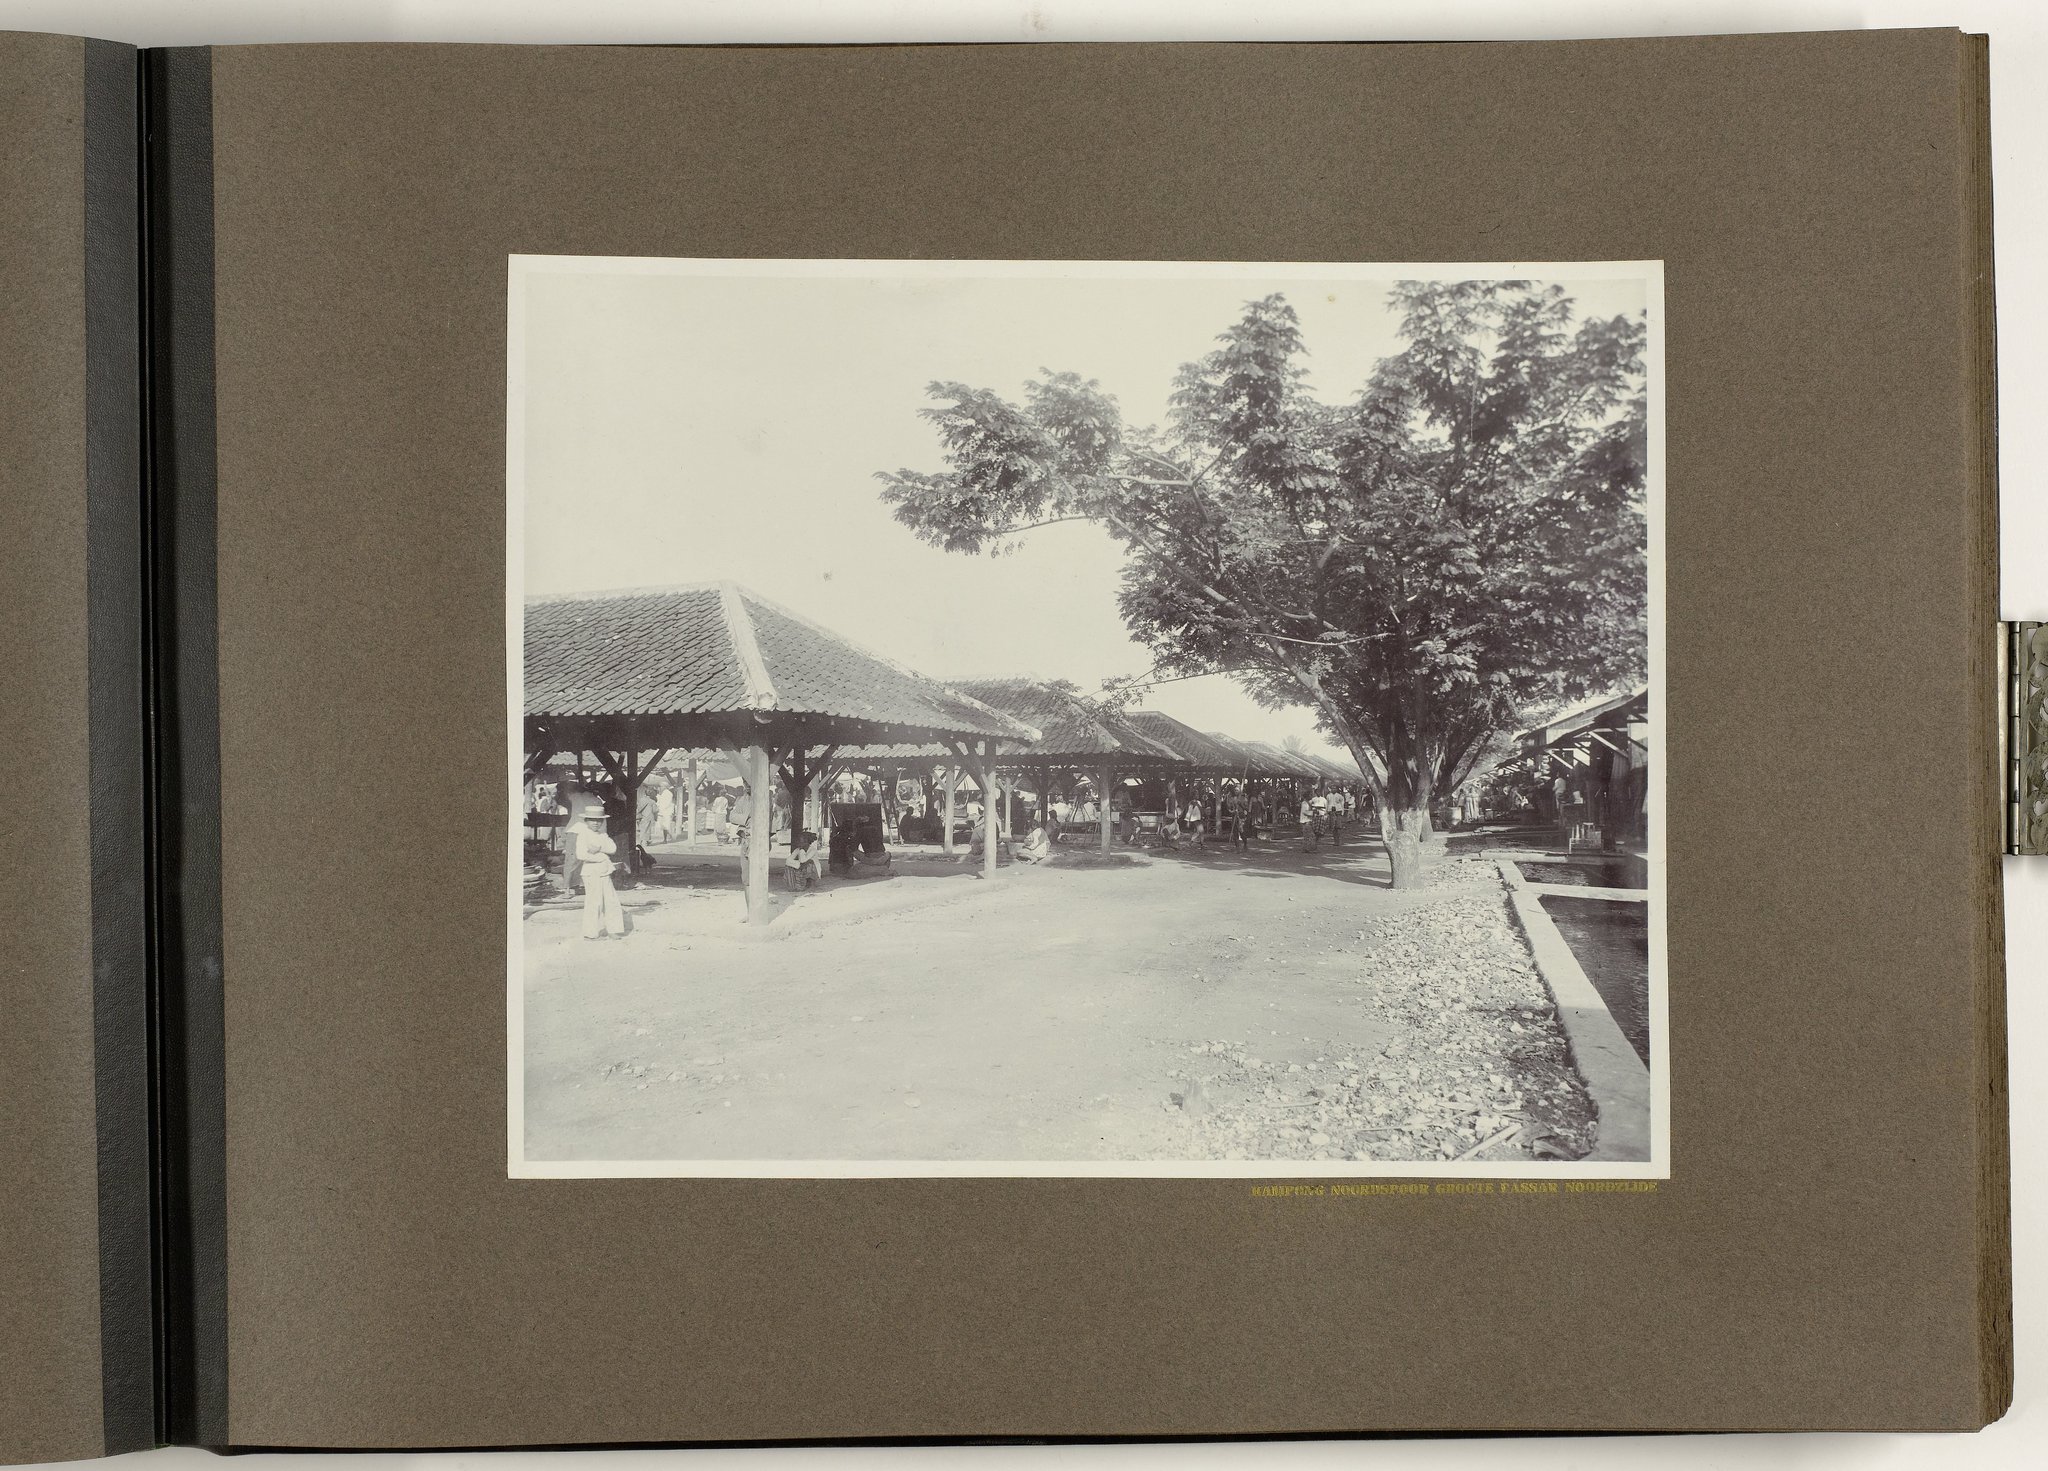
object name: photograph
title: Kampong noordspoor groote passar noordzijde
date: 1917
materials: photographic support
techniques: gelatin silver print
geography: jatiroto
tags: colonial system, prospect of village, silhouette of village, (non-fruit) products of plants or trees: sugarcane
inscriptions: inscription: ‘KAMPONG NOORDSPOOR GROOTE PASSAR NOORDZIJDE’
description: Terrein met marktstallen, bij het dorp van de werknemers van de suikerfabriek. Onderdeel van het fotoalbum aangeboden aan F.J. Wirix door het personeel van de Suikeronderneming Djatiroto in 1917.